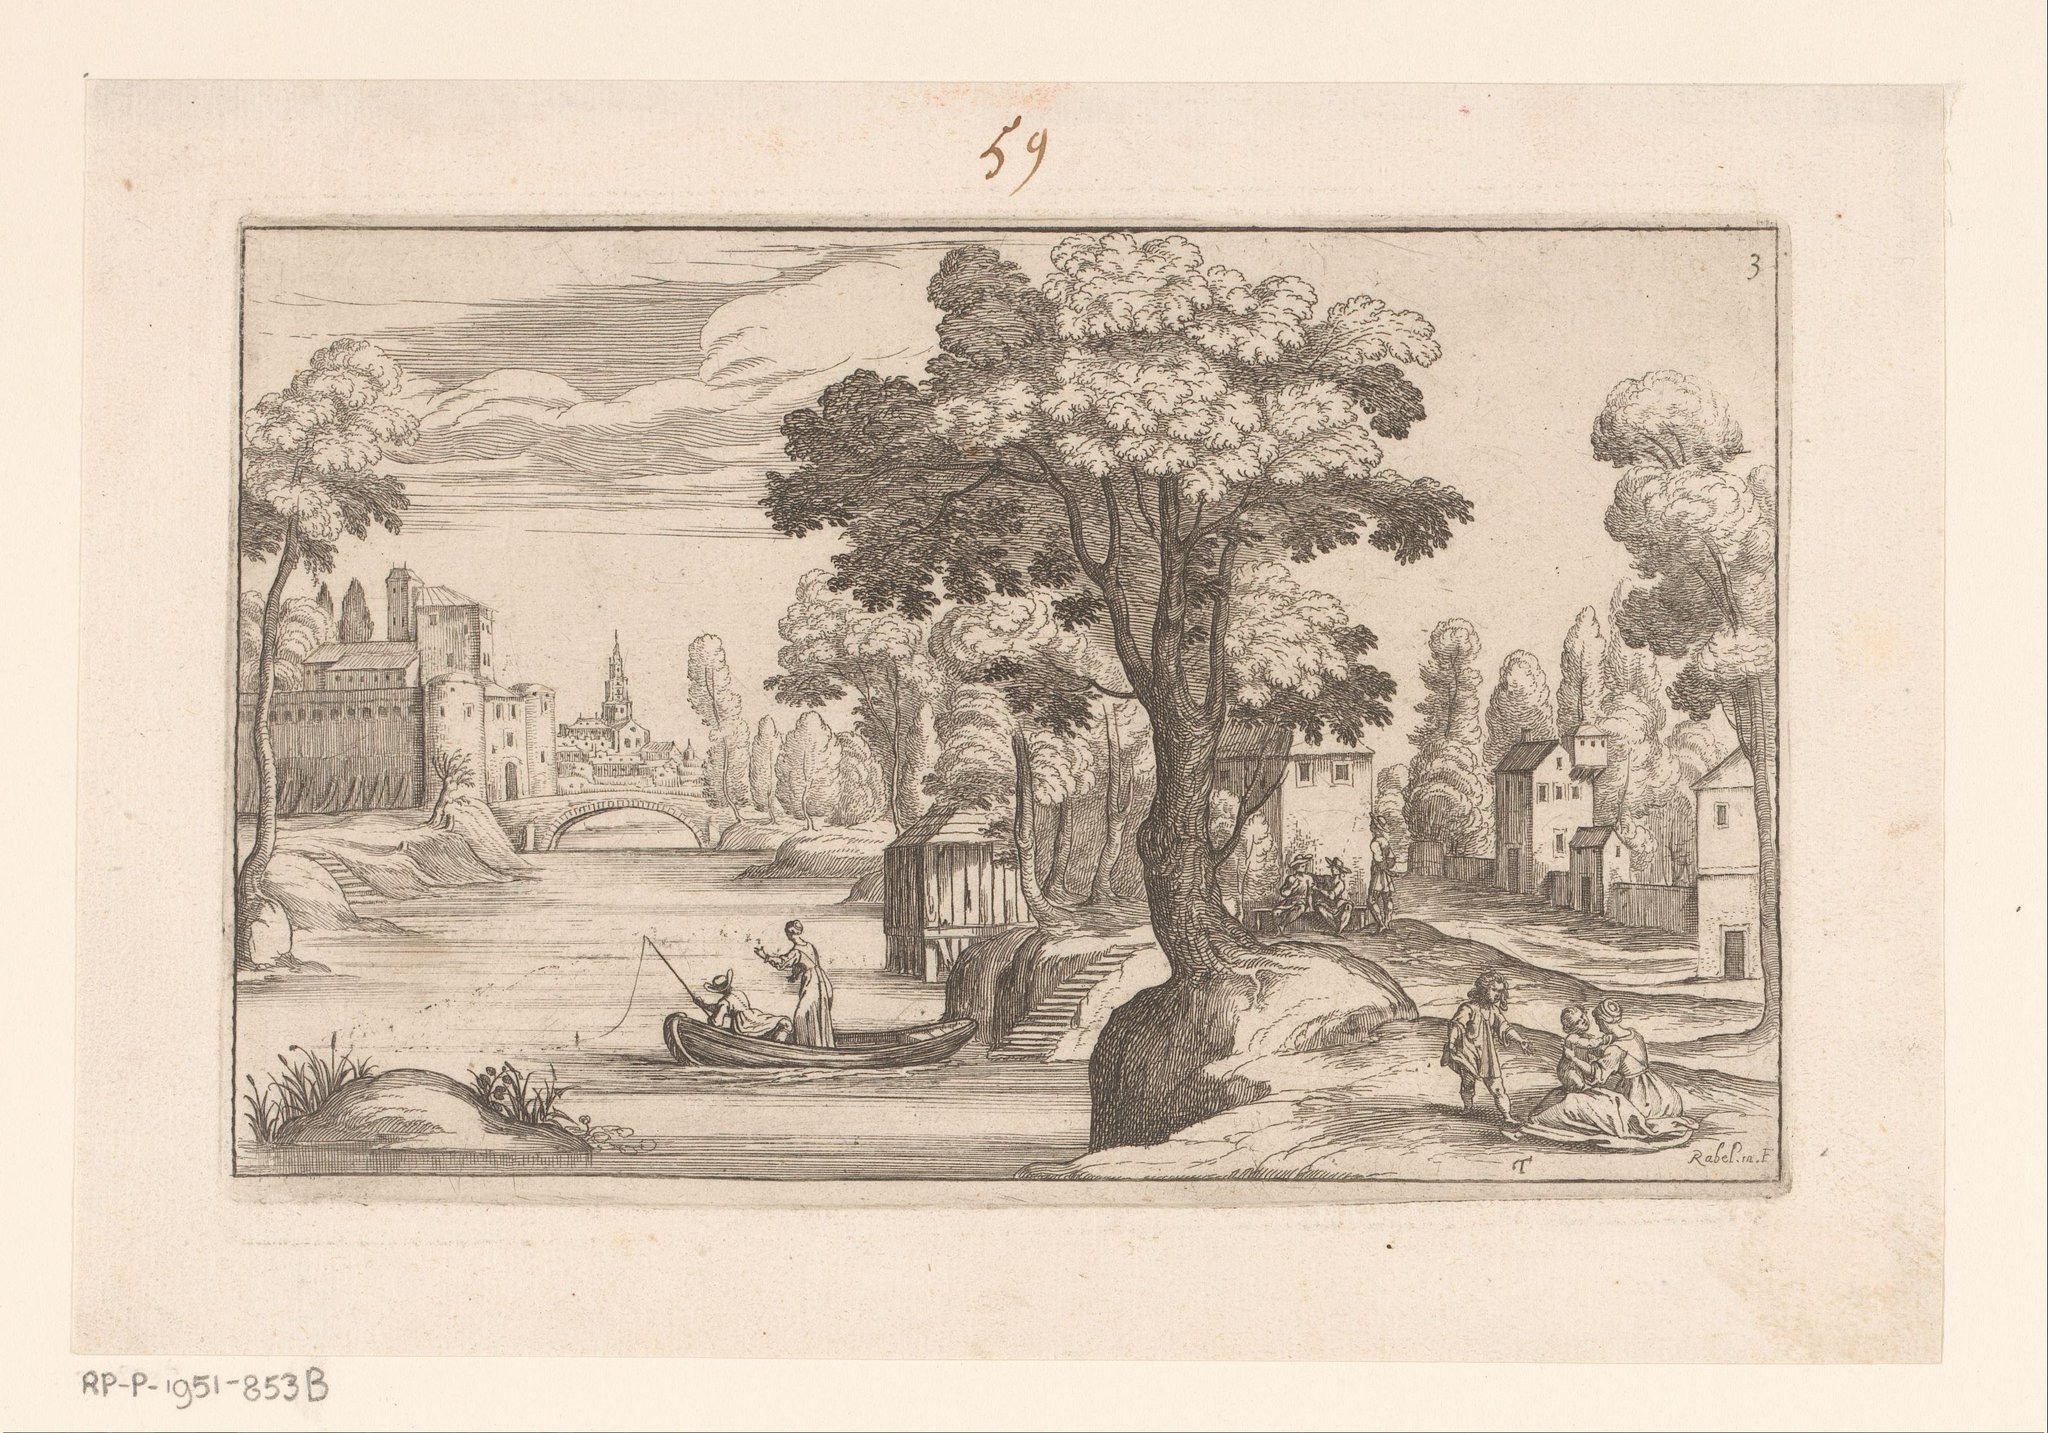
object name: print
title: Landschap met roeiboot in een rivier, in de verte een stad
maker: daniel rabel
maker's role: print maker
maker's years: 1578-1637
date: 1588-1637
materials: paper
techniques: etching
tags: landscape with bridge, viaduct or aqueduct (+ city(-scape) with figures, staffage)